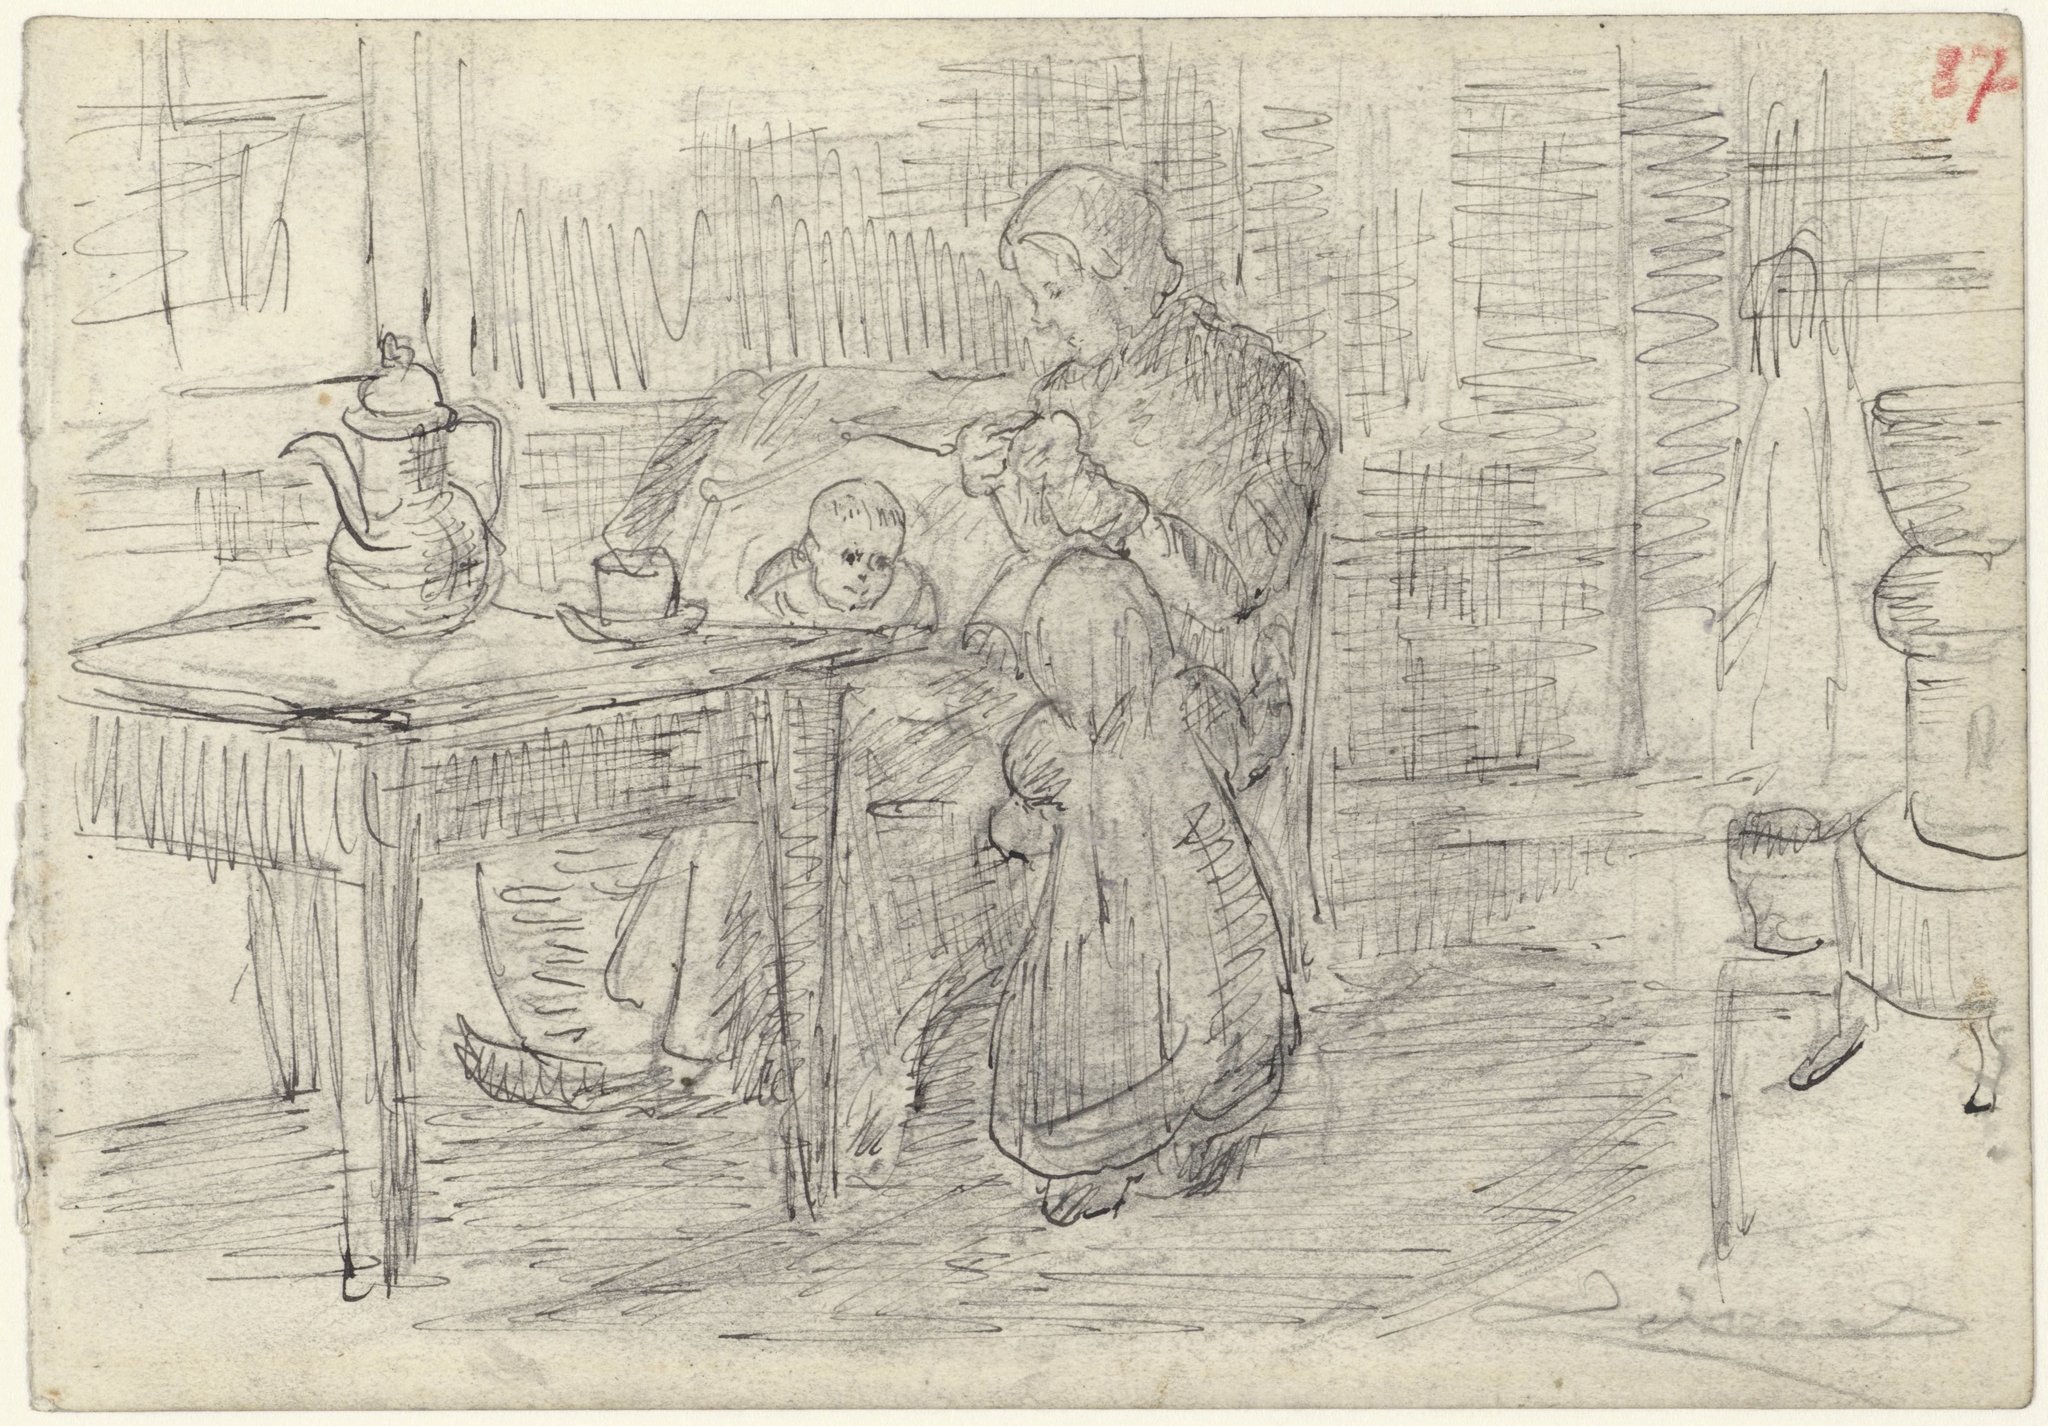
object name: drawing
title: Interieur met handwerkende vrouw met twee kinderen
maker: jozef israëls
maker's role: draughtsman, painter, print maker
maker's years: 1824-1911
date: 1834-1911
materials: ink, paper, pencil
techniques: pen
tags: interior of the house, mother and baby or young child, (other forms of) needlework, e.g.: crocheting, knitting, embroidering